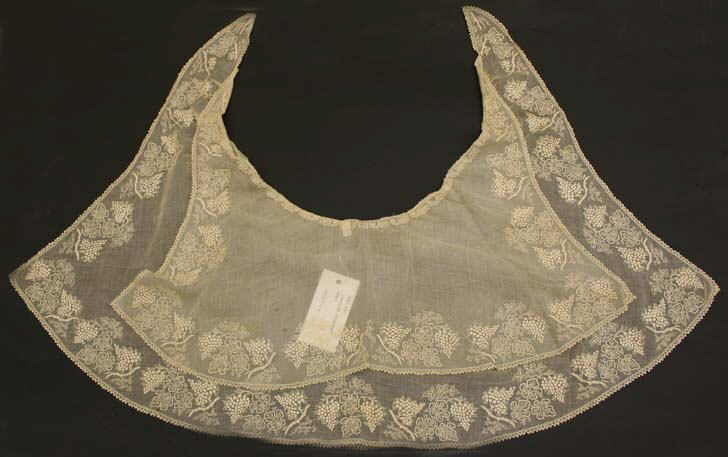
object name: pelerine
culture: american or european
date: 1830-1839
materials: cotton